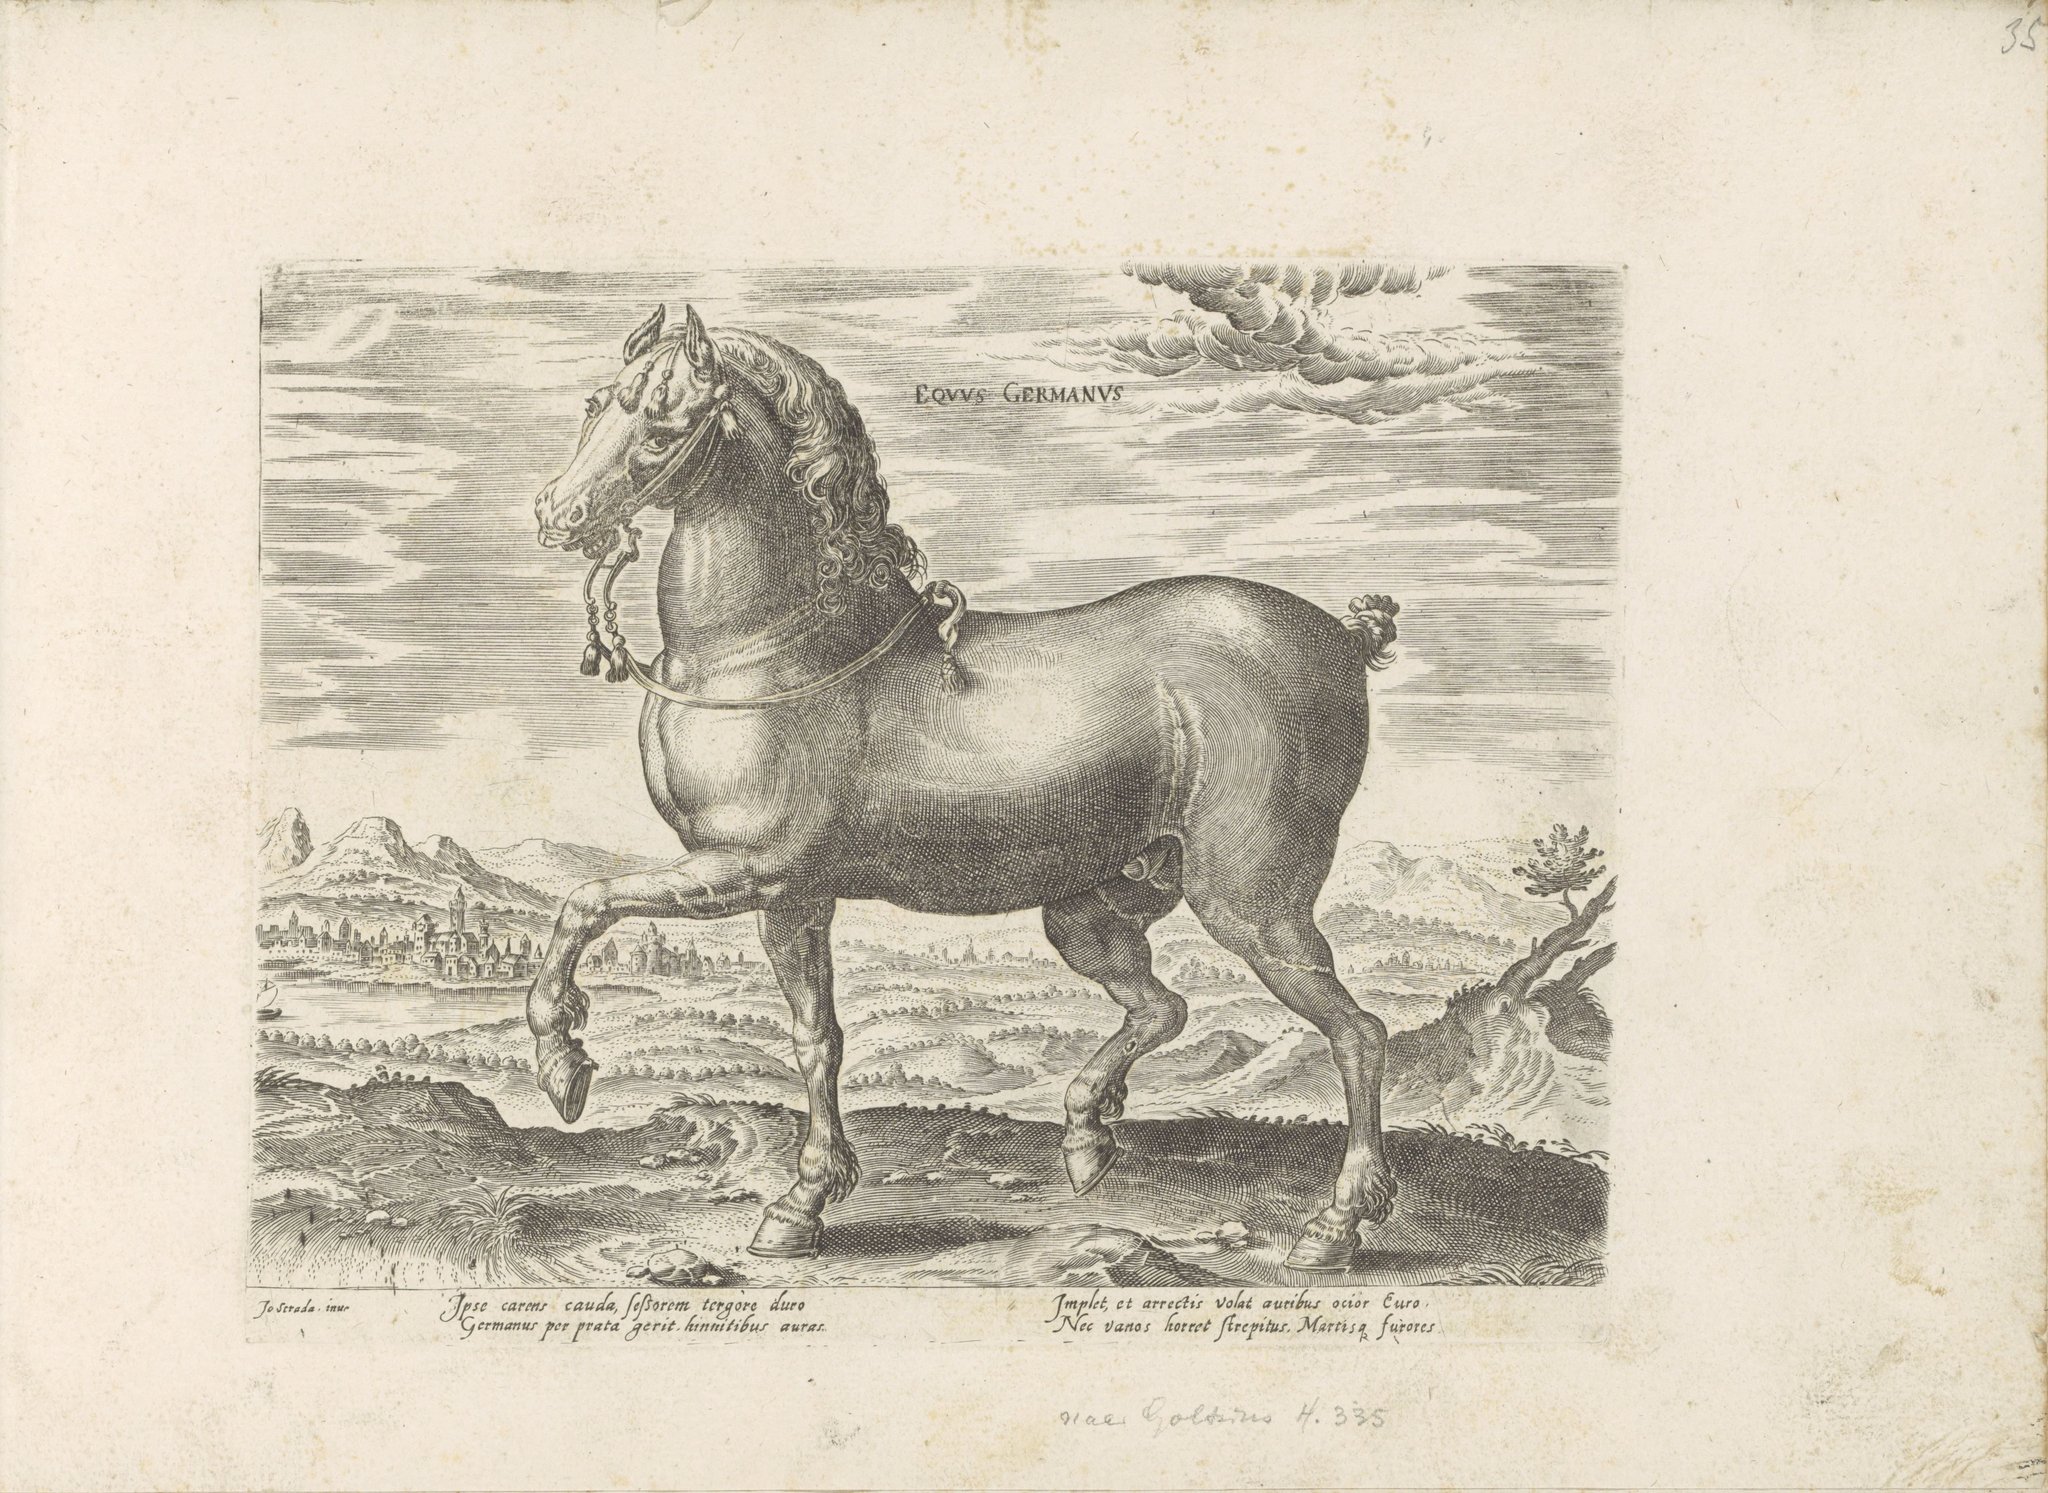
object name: album leaf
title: Equile, in quo omnis generis generosissi: morum equorum ex varijs orbis partibus insignis delectus (...)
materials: paper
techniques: engraving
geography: venice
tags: don juan van oostenrijk, horses and kindred animals, germany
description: Een Duits paard in een landschap. Prent maakt deel uit van een album.